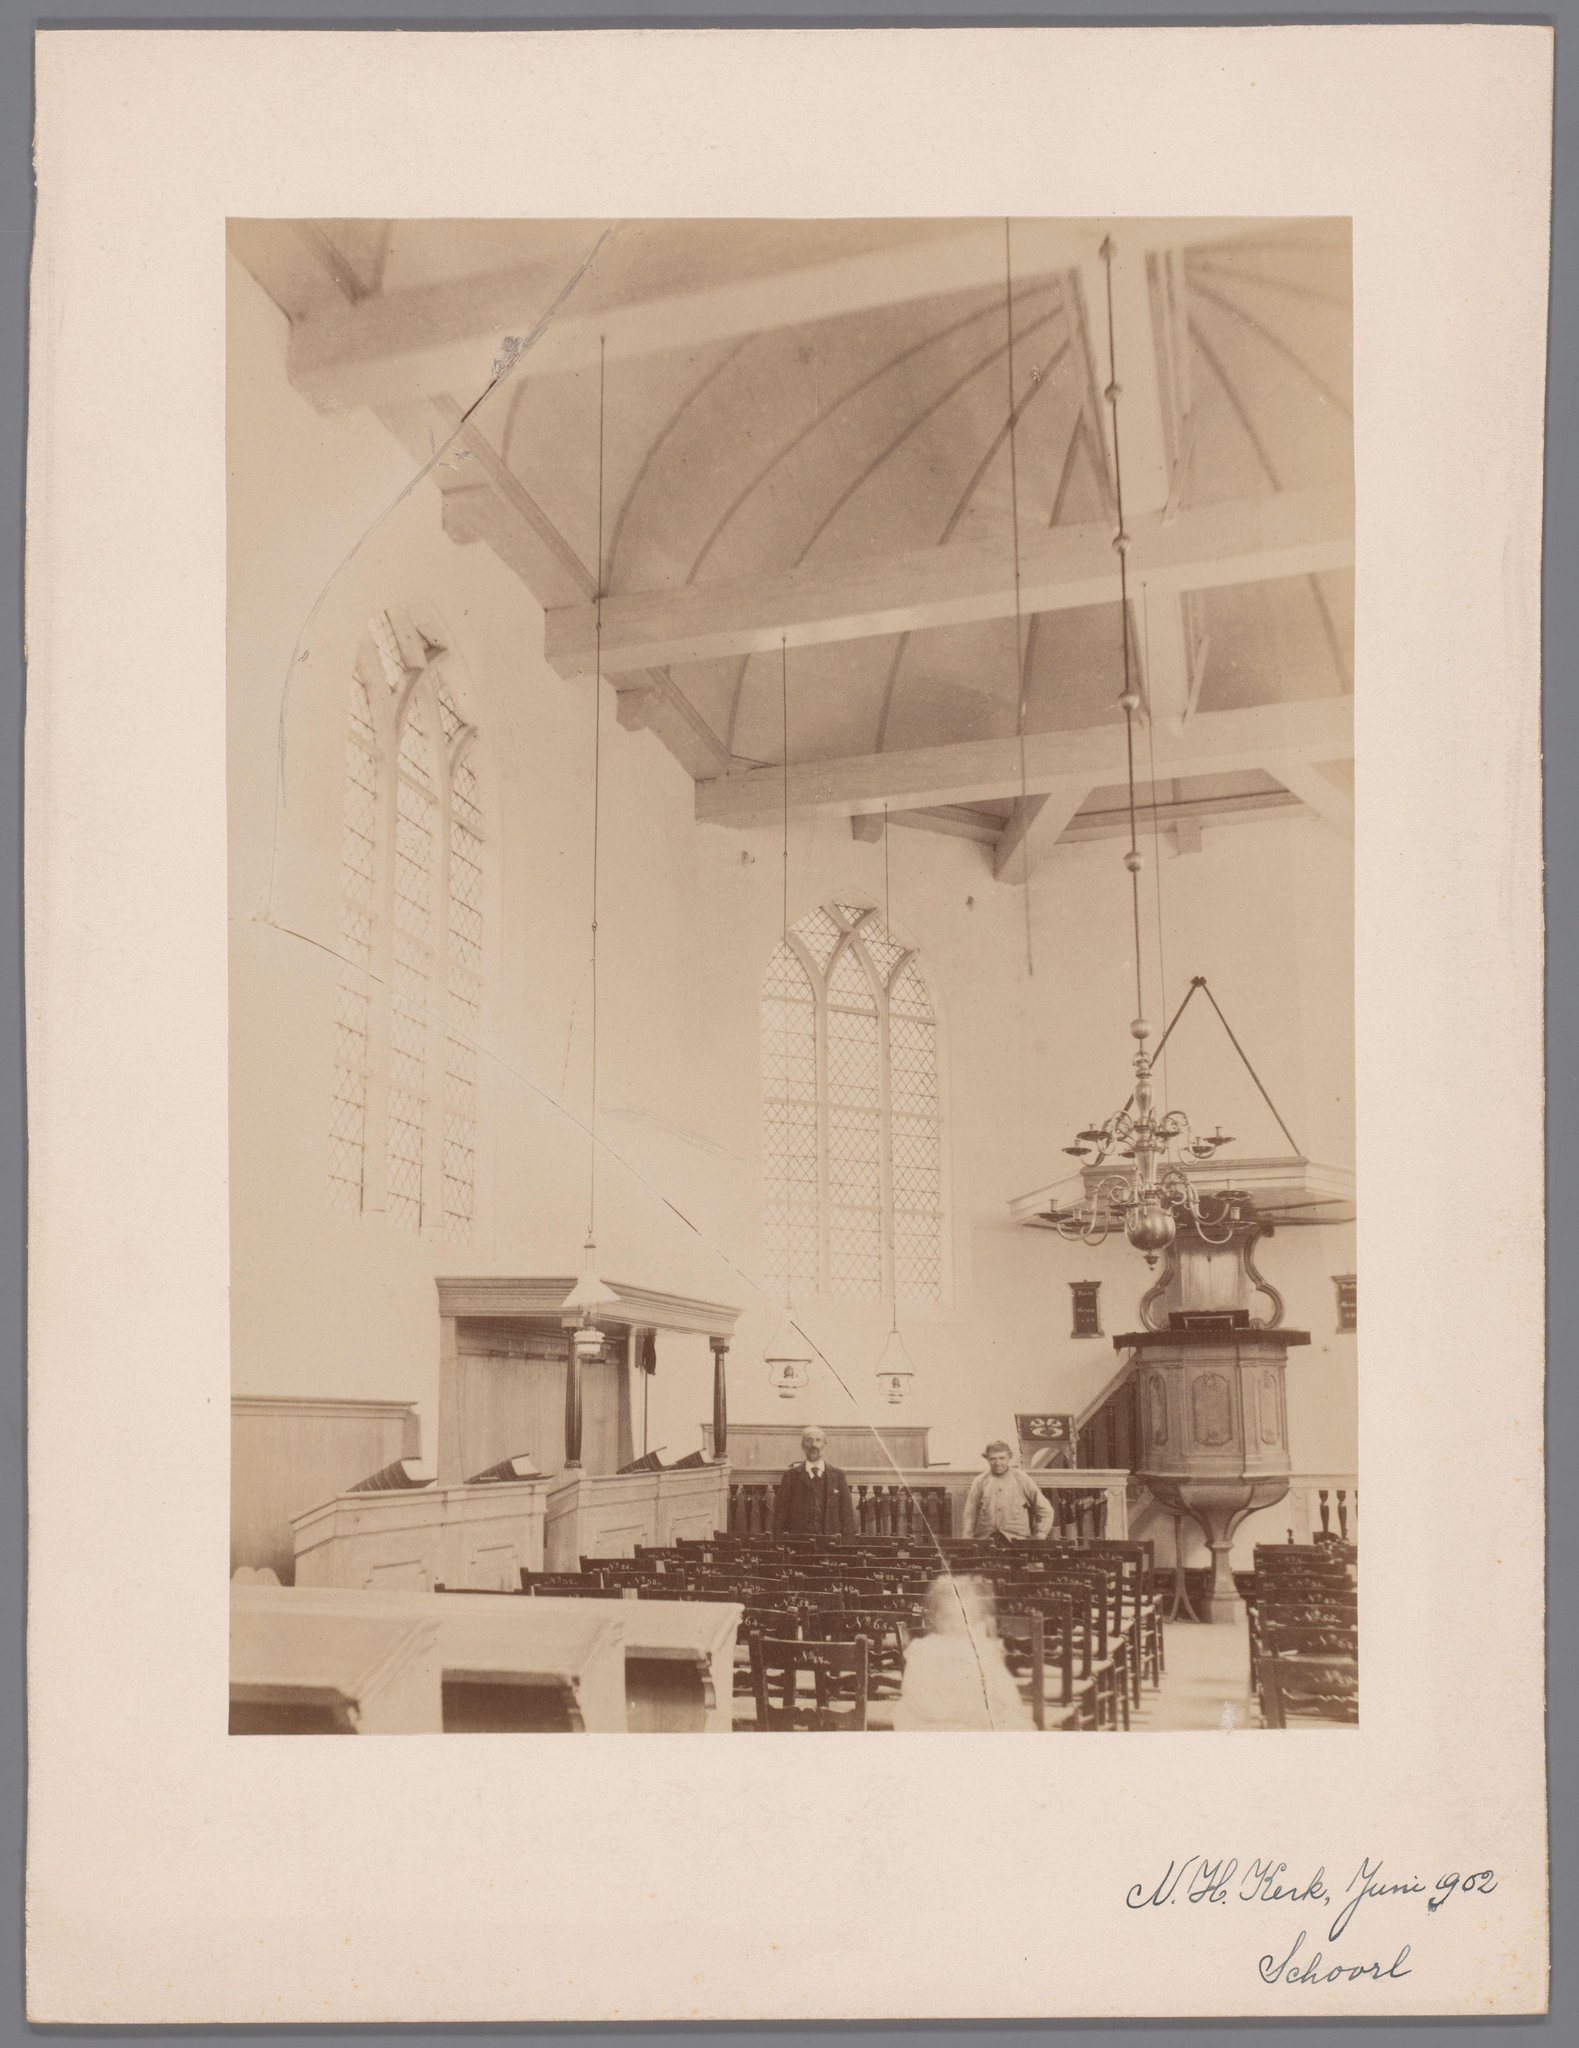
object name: photograph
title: Interieur van de Hervormde Kerk te Schoorl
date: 1902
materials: cardboard, photographic support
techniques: albumen print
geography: schoorl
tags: interior of church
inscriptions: annotation: ‘N.H. Kerk, Juni 1902/ Schoorl’, annotation: ‘Schoorl (N.H.)/ N.H. Kerk/ inerieur/ Juni 1902’